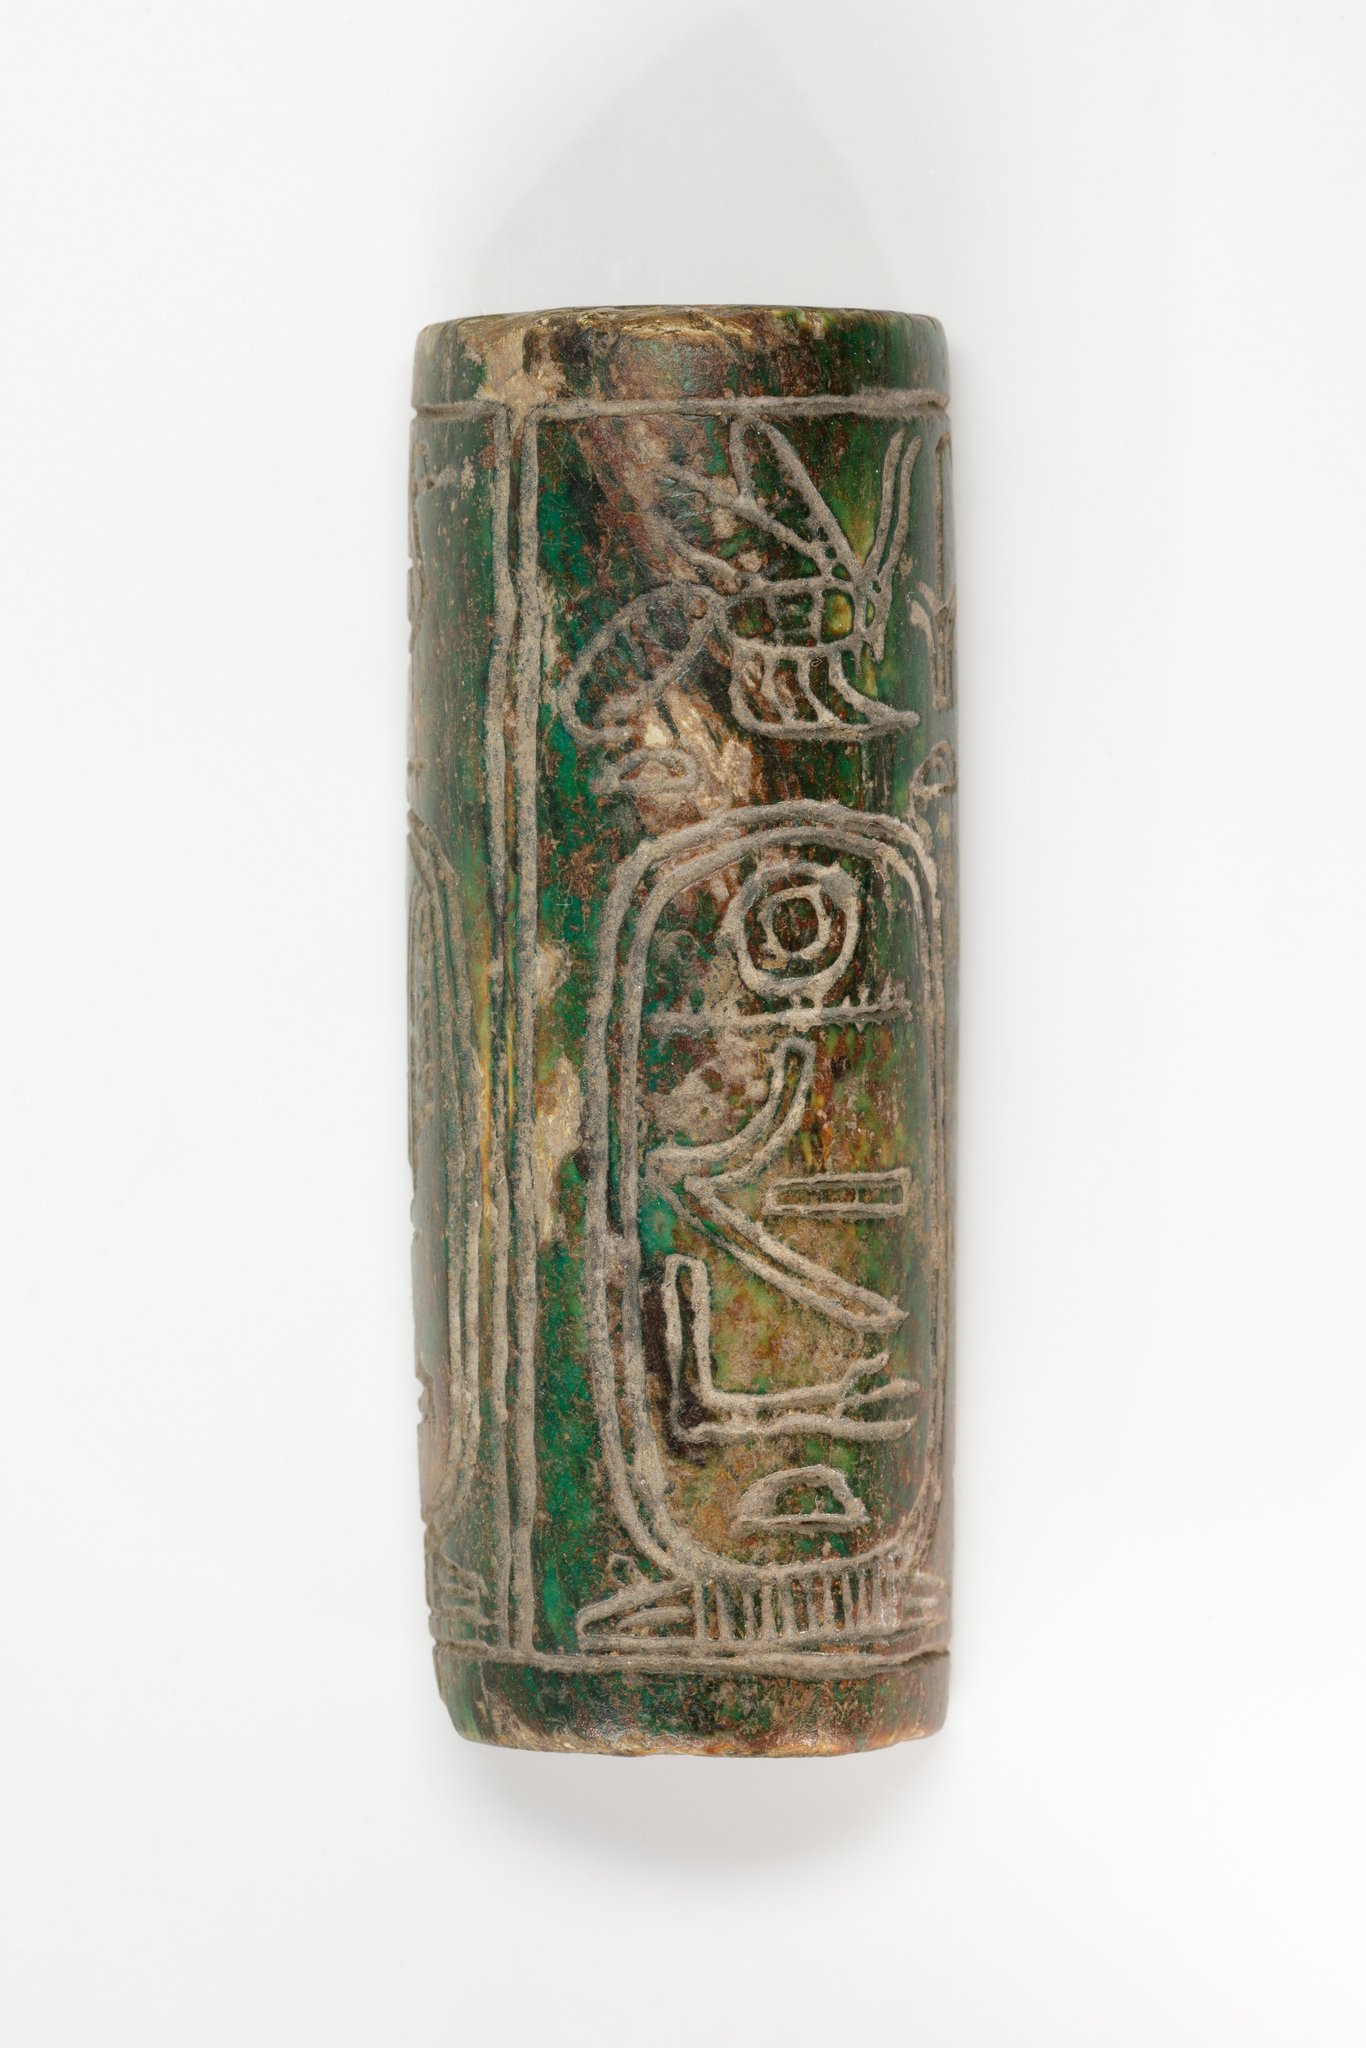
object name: cylinder seal, amenemhat iii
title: Half of a cylinder seal with names of Amenemhat III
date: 1859-1813 BCE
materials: stone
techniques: glazing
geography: egypt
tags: cartouches